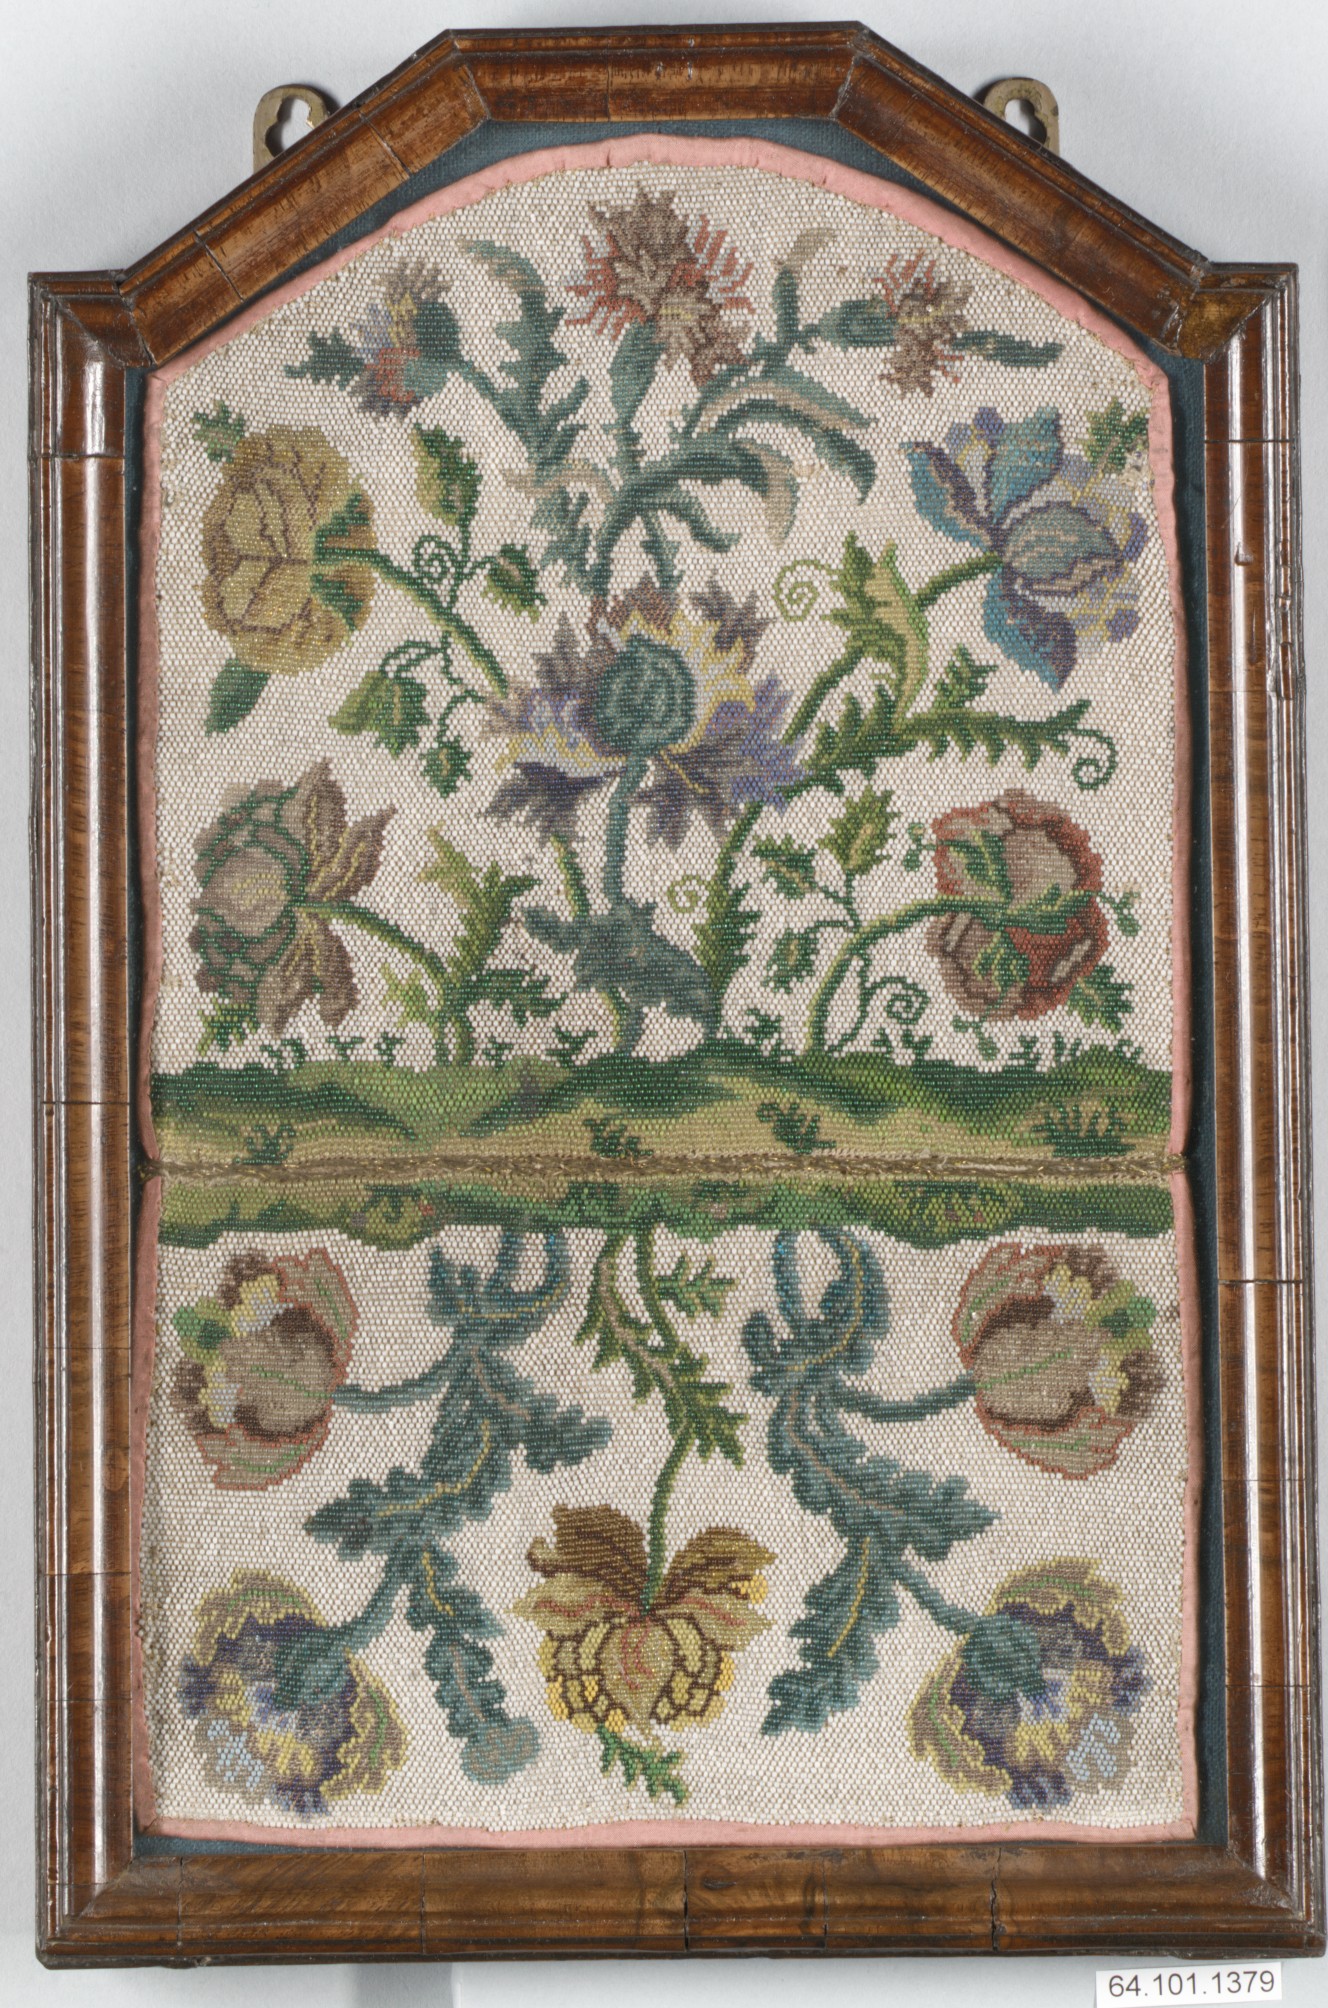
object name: letter case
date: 1726-1750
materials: silk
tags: flowers